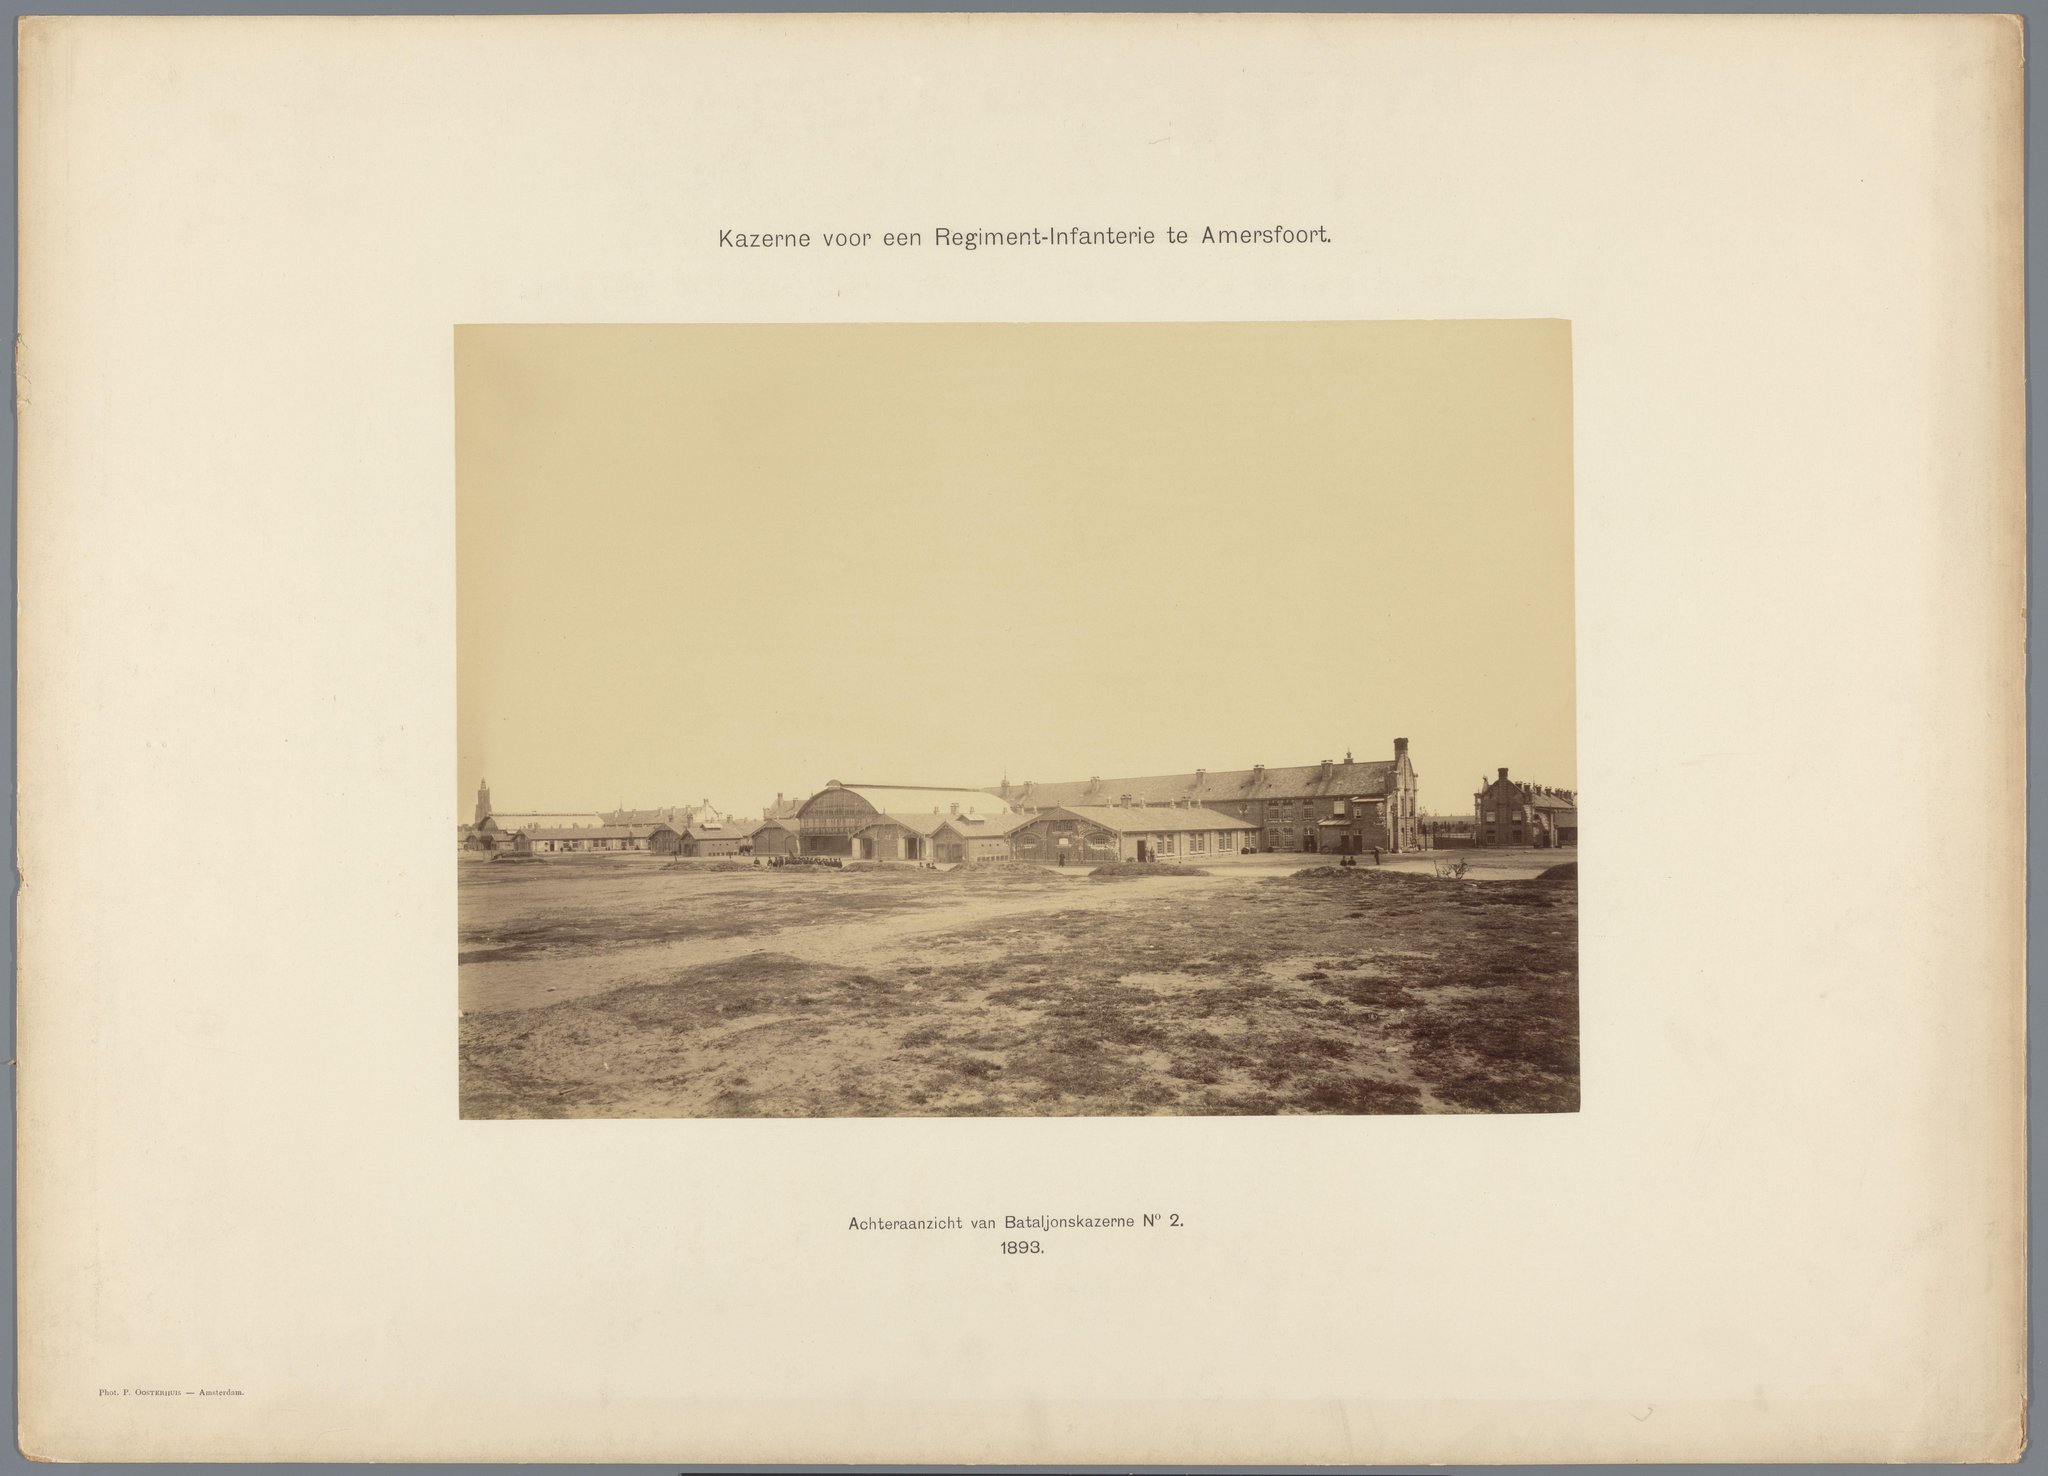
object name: photograph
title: Kazerne voor een Regiment Infanterie te Amersfoort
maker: p. oosterhuis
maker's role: fotograaf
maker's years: 1816-1885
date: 1892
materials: cardboard, paper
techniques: photography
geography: amersfoort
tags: netherlands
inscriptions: date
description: Foto, geelbruin, op karton, met boven titel en onder omschrijving. Opschrift; m.o.: '..Bataljonskazerne No 2..'